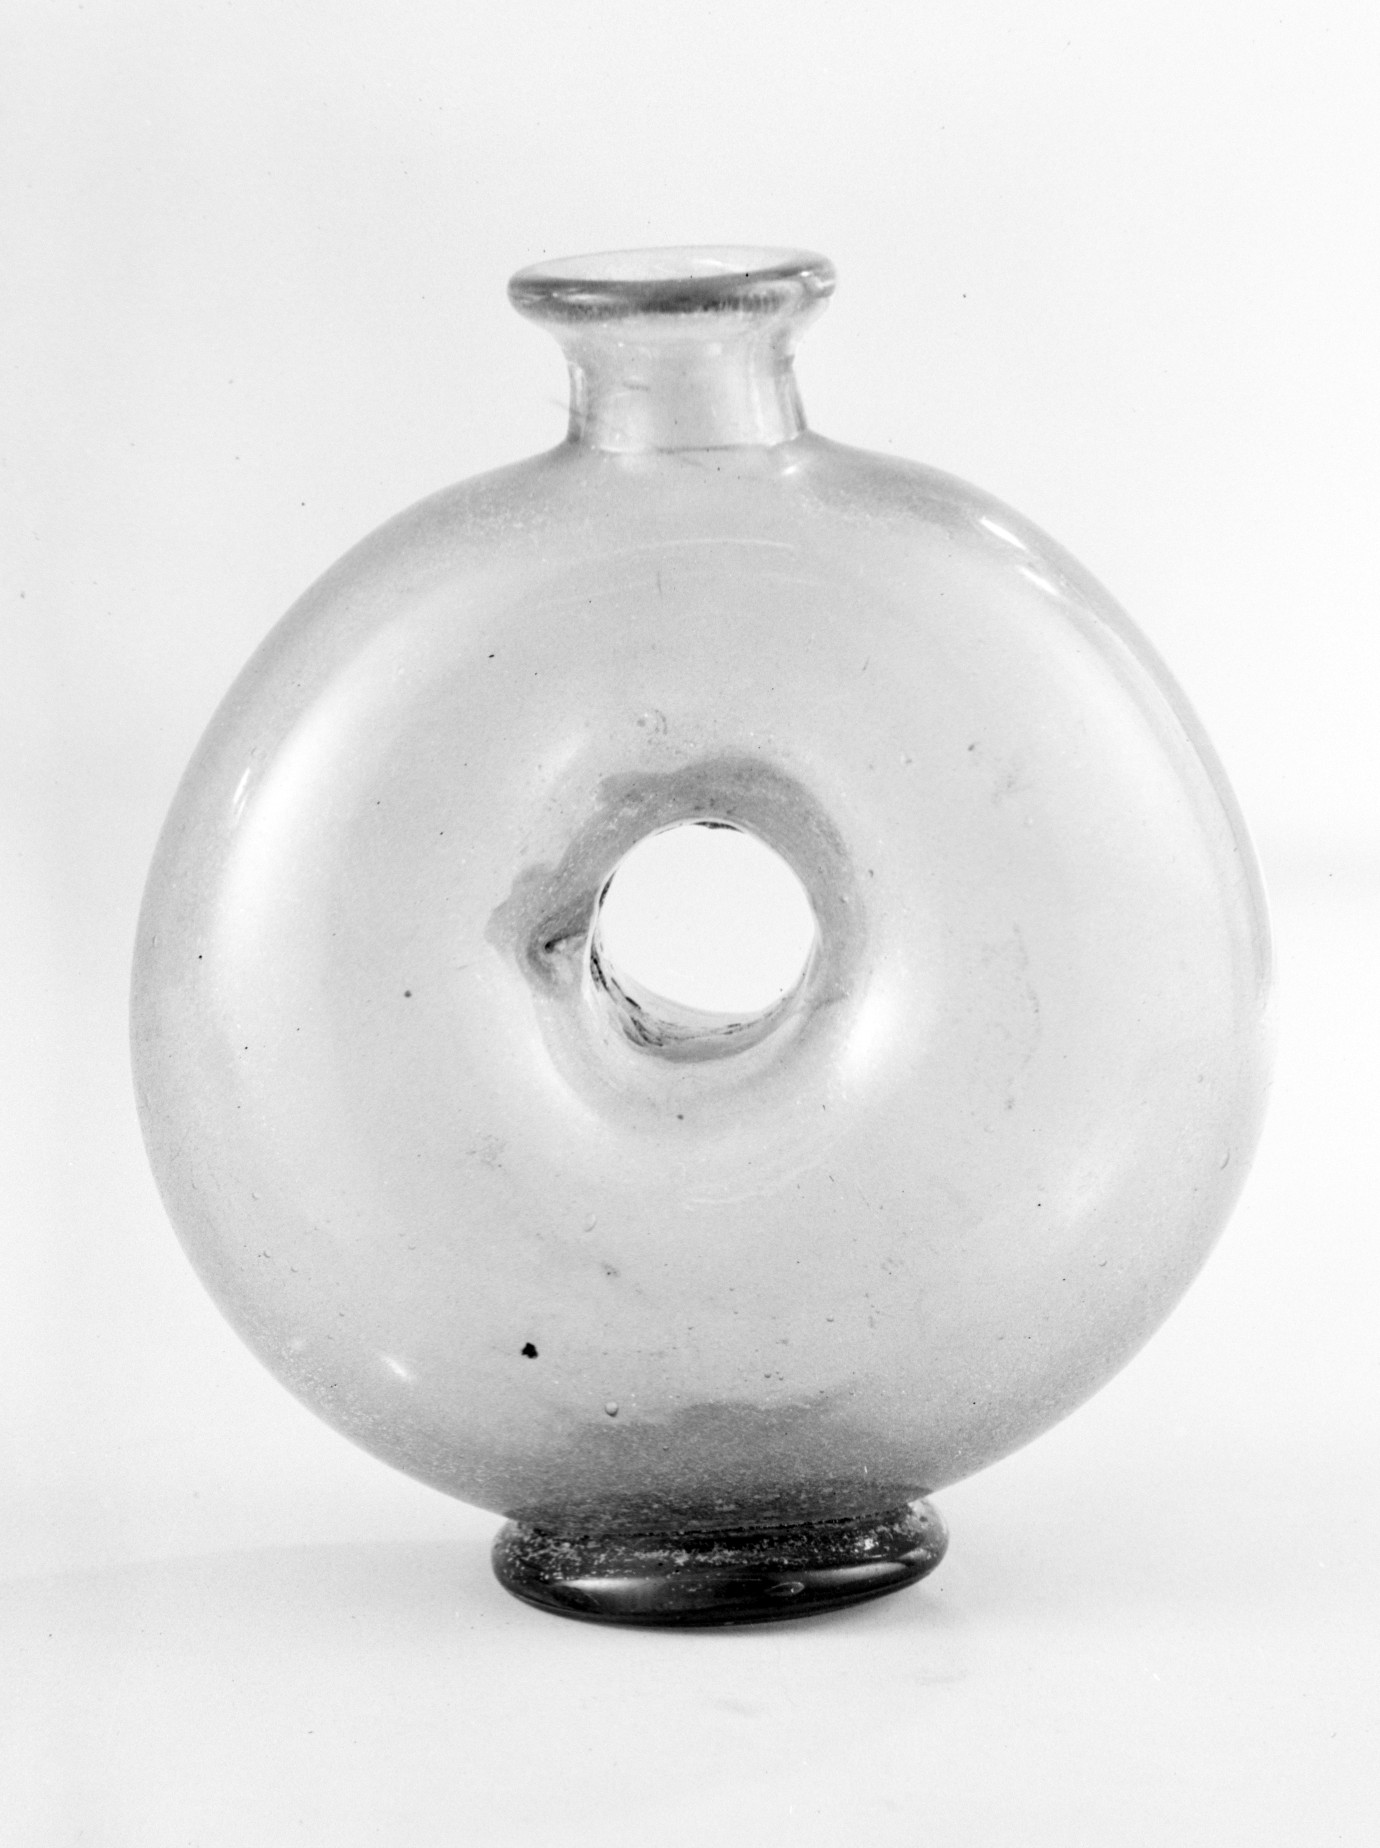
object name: pilgrim bottle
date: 1601-1700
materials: glass